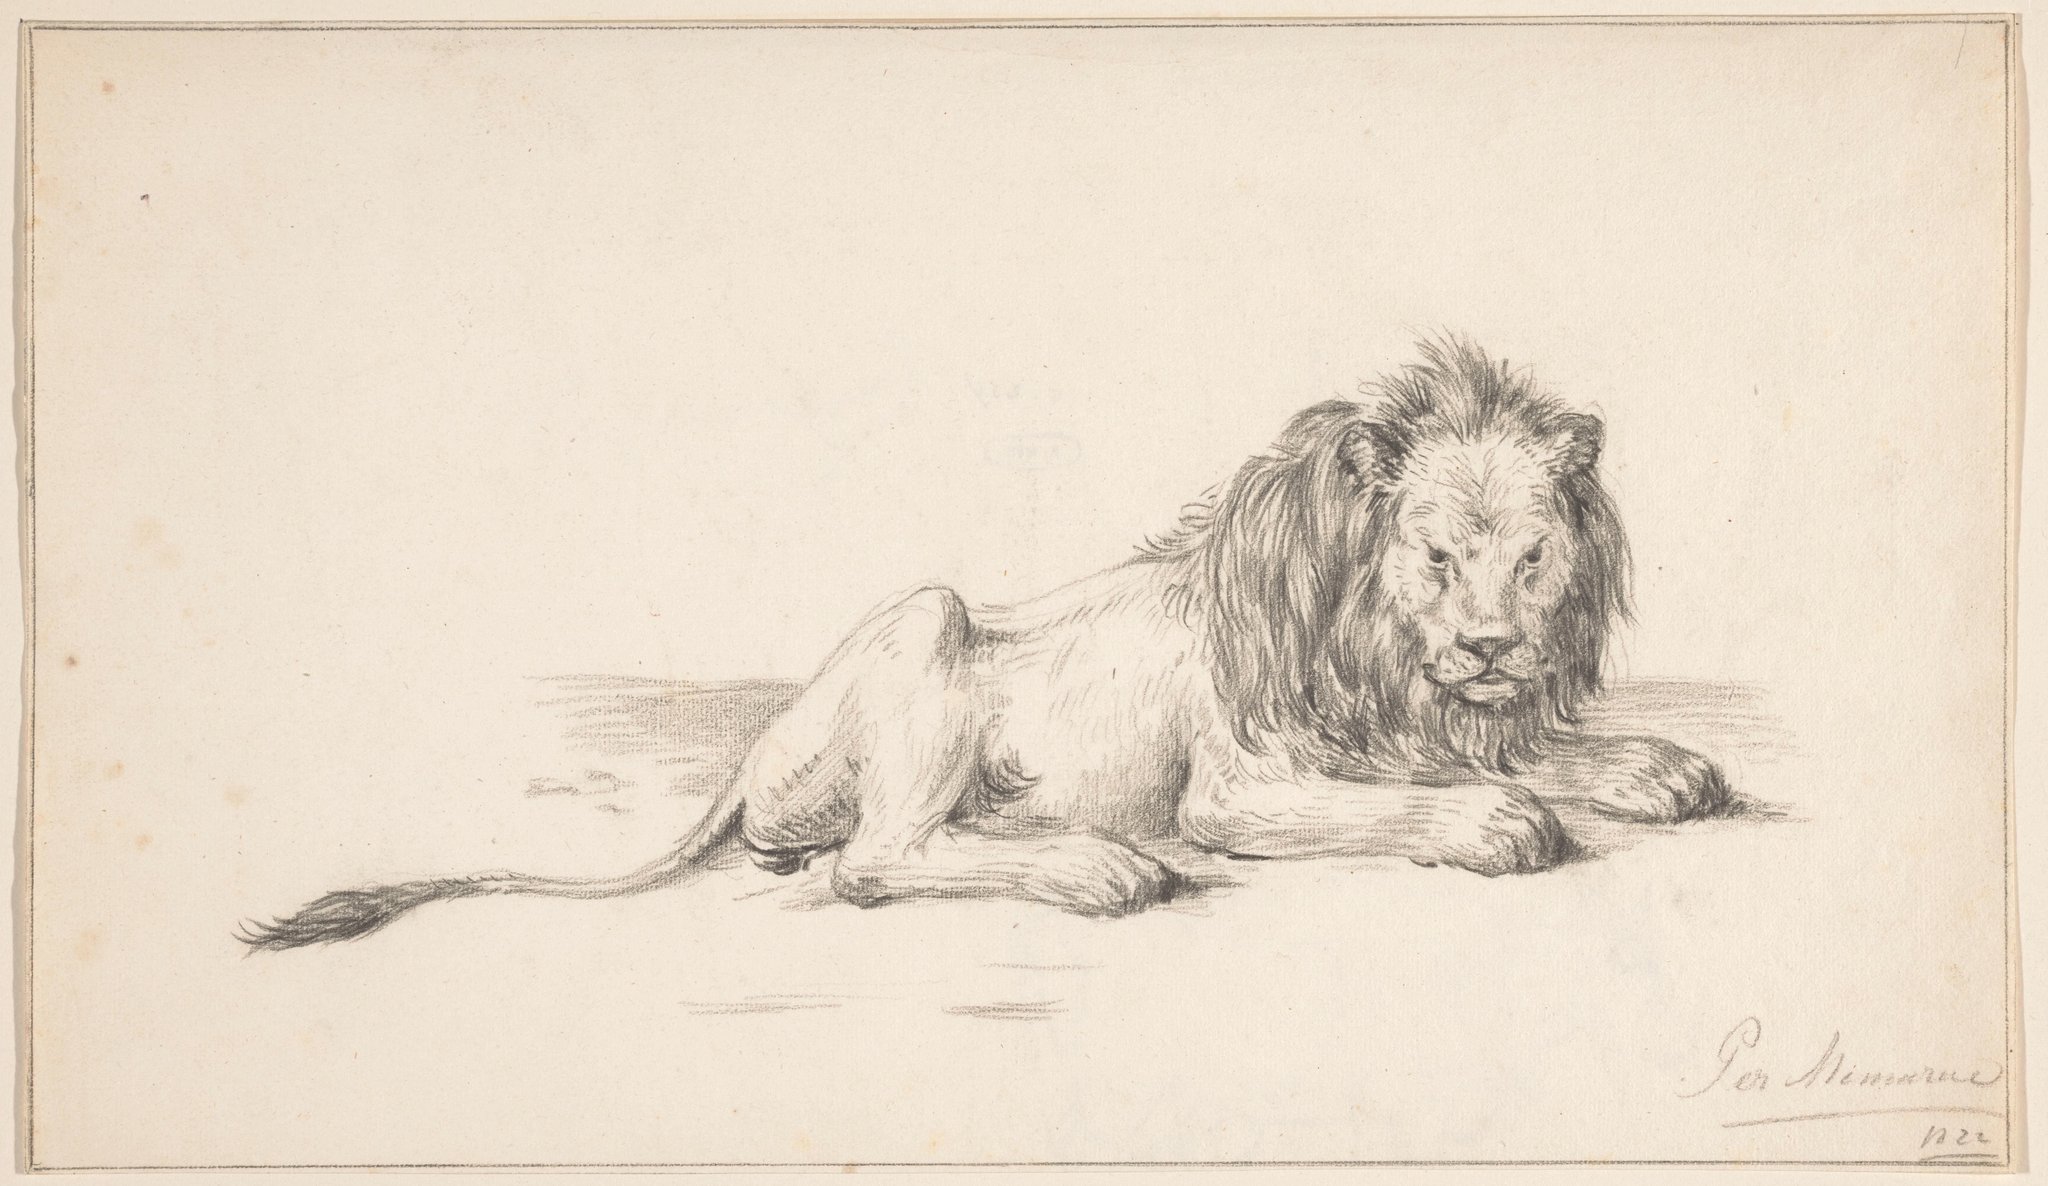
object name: drawing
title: Liggende leeuw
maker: jean bernard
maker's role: draughtsman, print maker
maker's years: 1765-1833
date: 1822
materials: chalk, paper, pencil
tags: beasts of prey, predatory animals: lion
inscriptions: date: ‘1822’, inscription: ‘Per Memoriee’